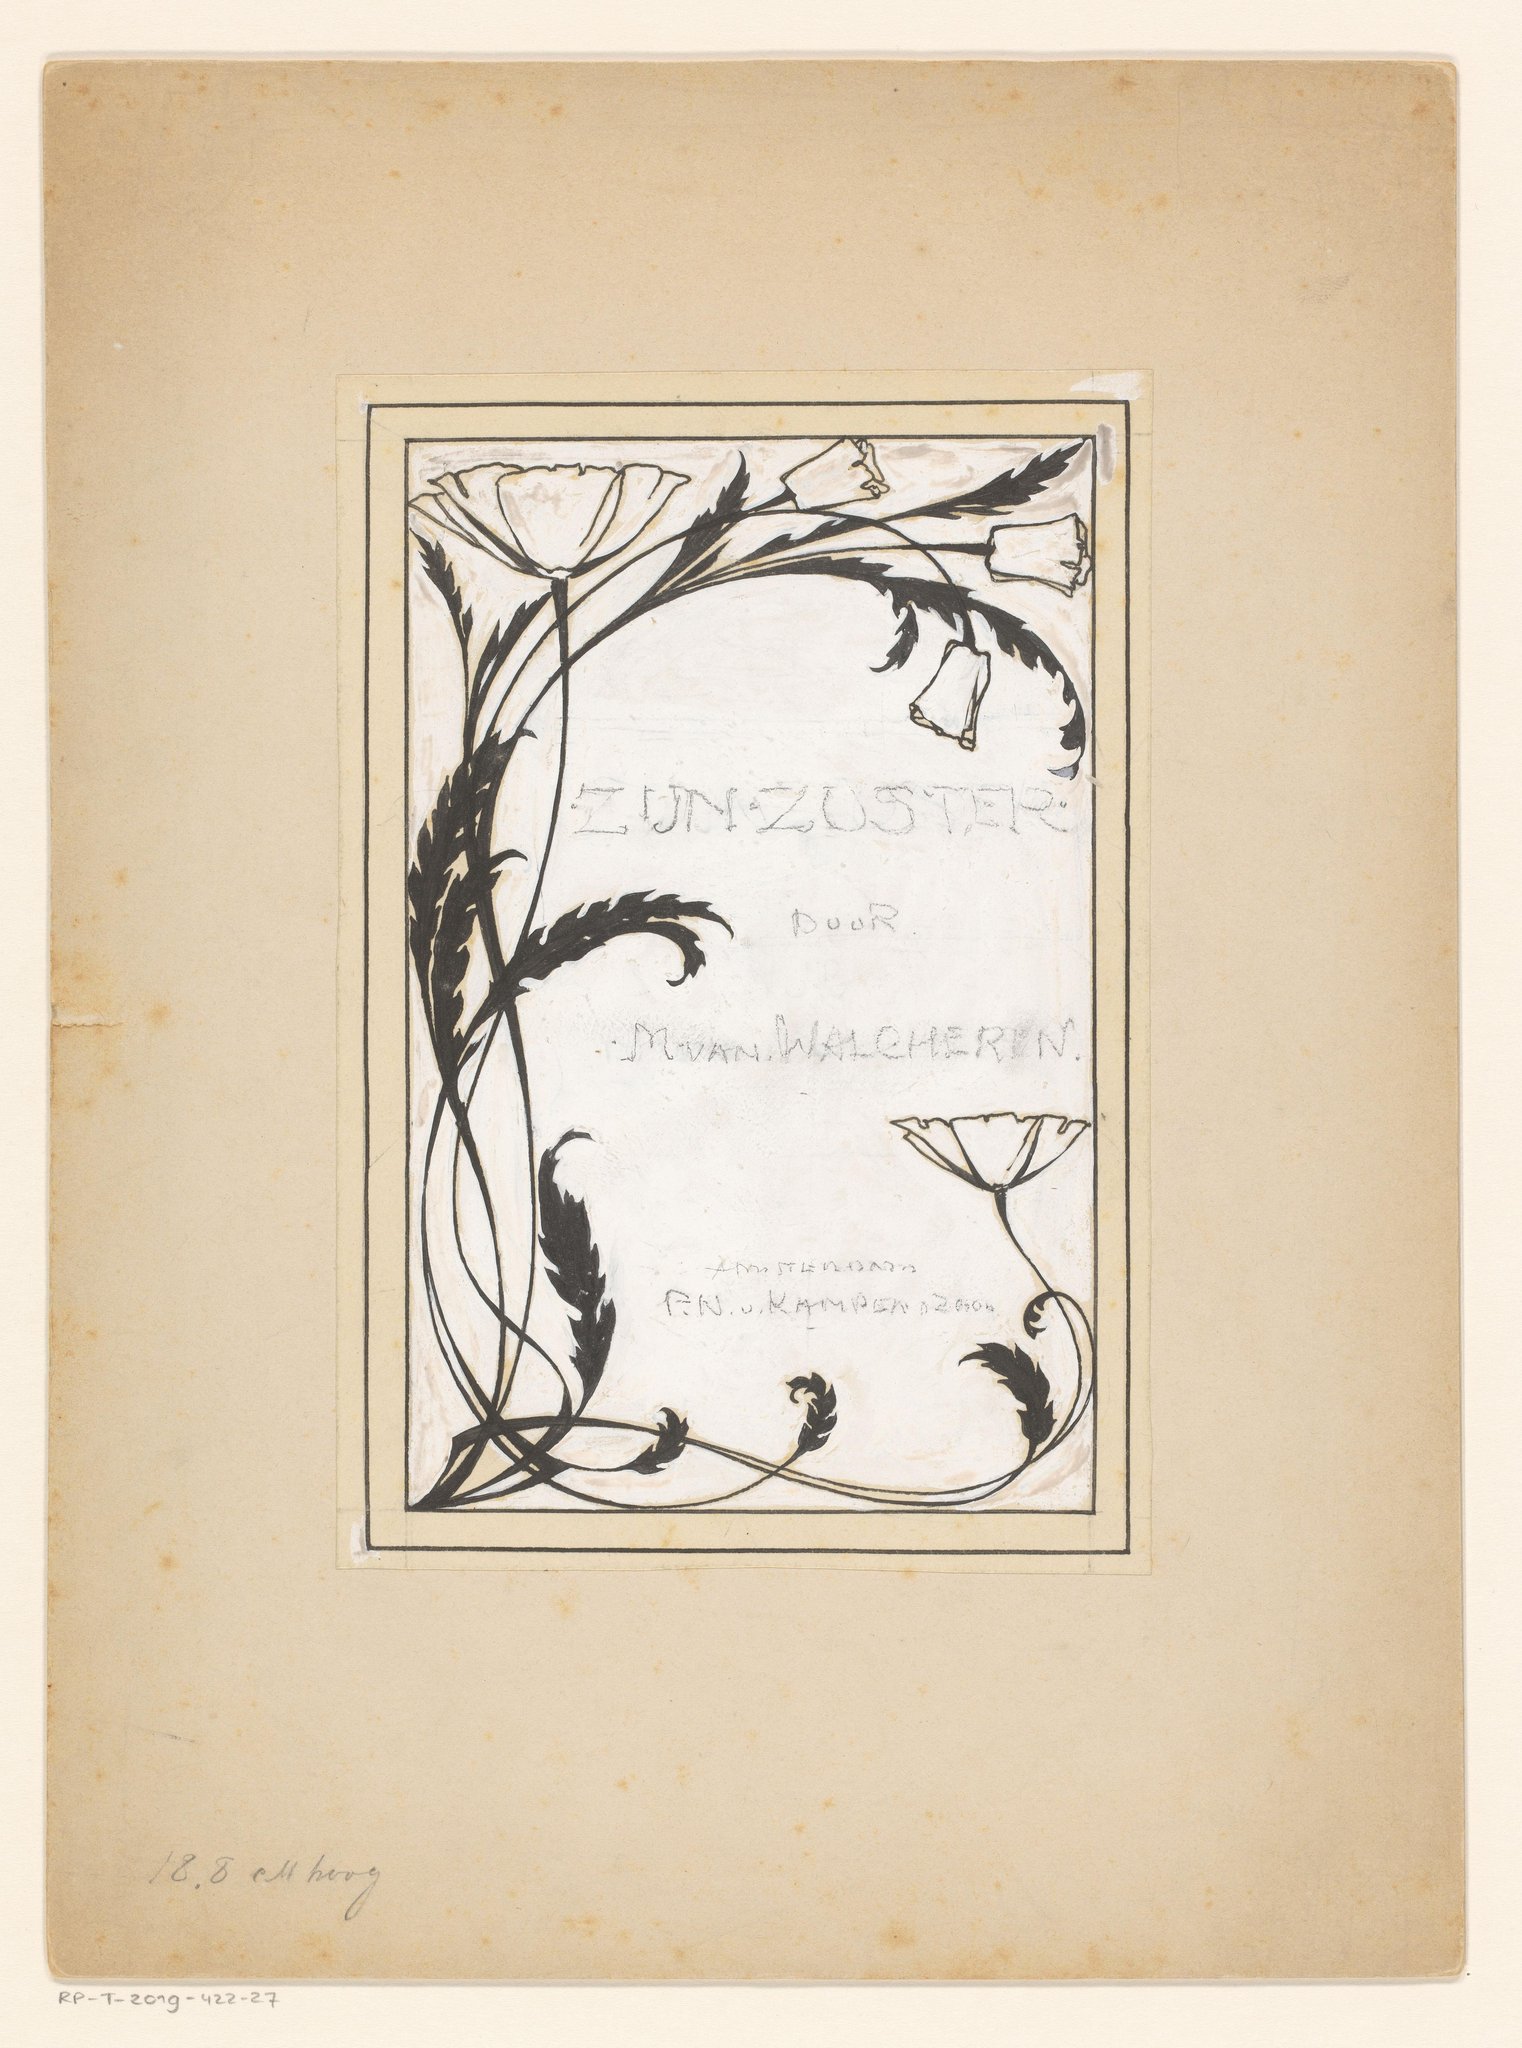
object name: drawing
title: Bandontwerp voor: M. van Walcheren, Zijn zuster, 1899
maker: willem wenckebach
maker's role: designer, draughtsman, painter, print maker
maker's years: 1860-1937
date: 1899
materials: cardboard, paint, ink, paper, pencil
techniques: brush, pen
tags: flowers ~ ornament - aa - stylized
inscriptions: collector's mark: Lugt 2228, :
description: Bandontwerp voor: Walcheren, M. van. Zijn zuster. Amsterdam: Van Kampen, 1899.